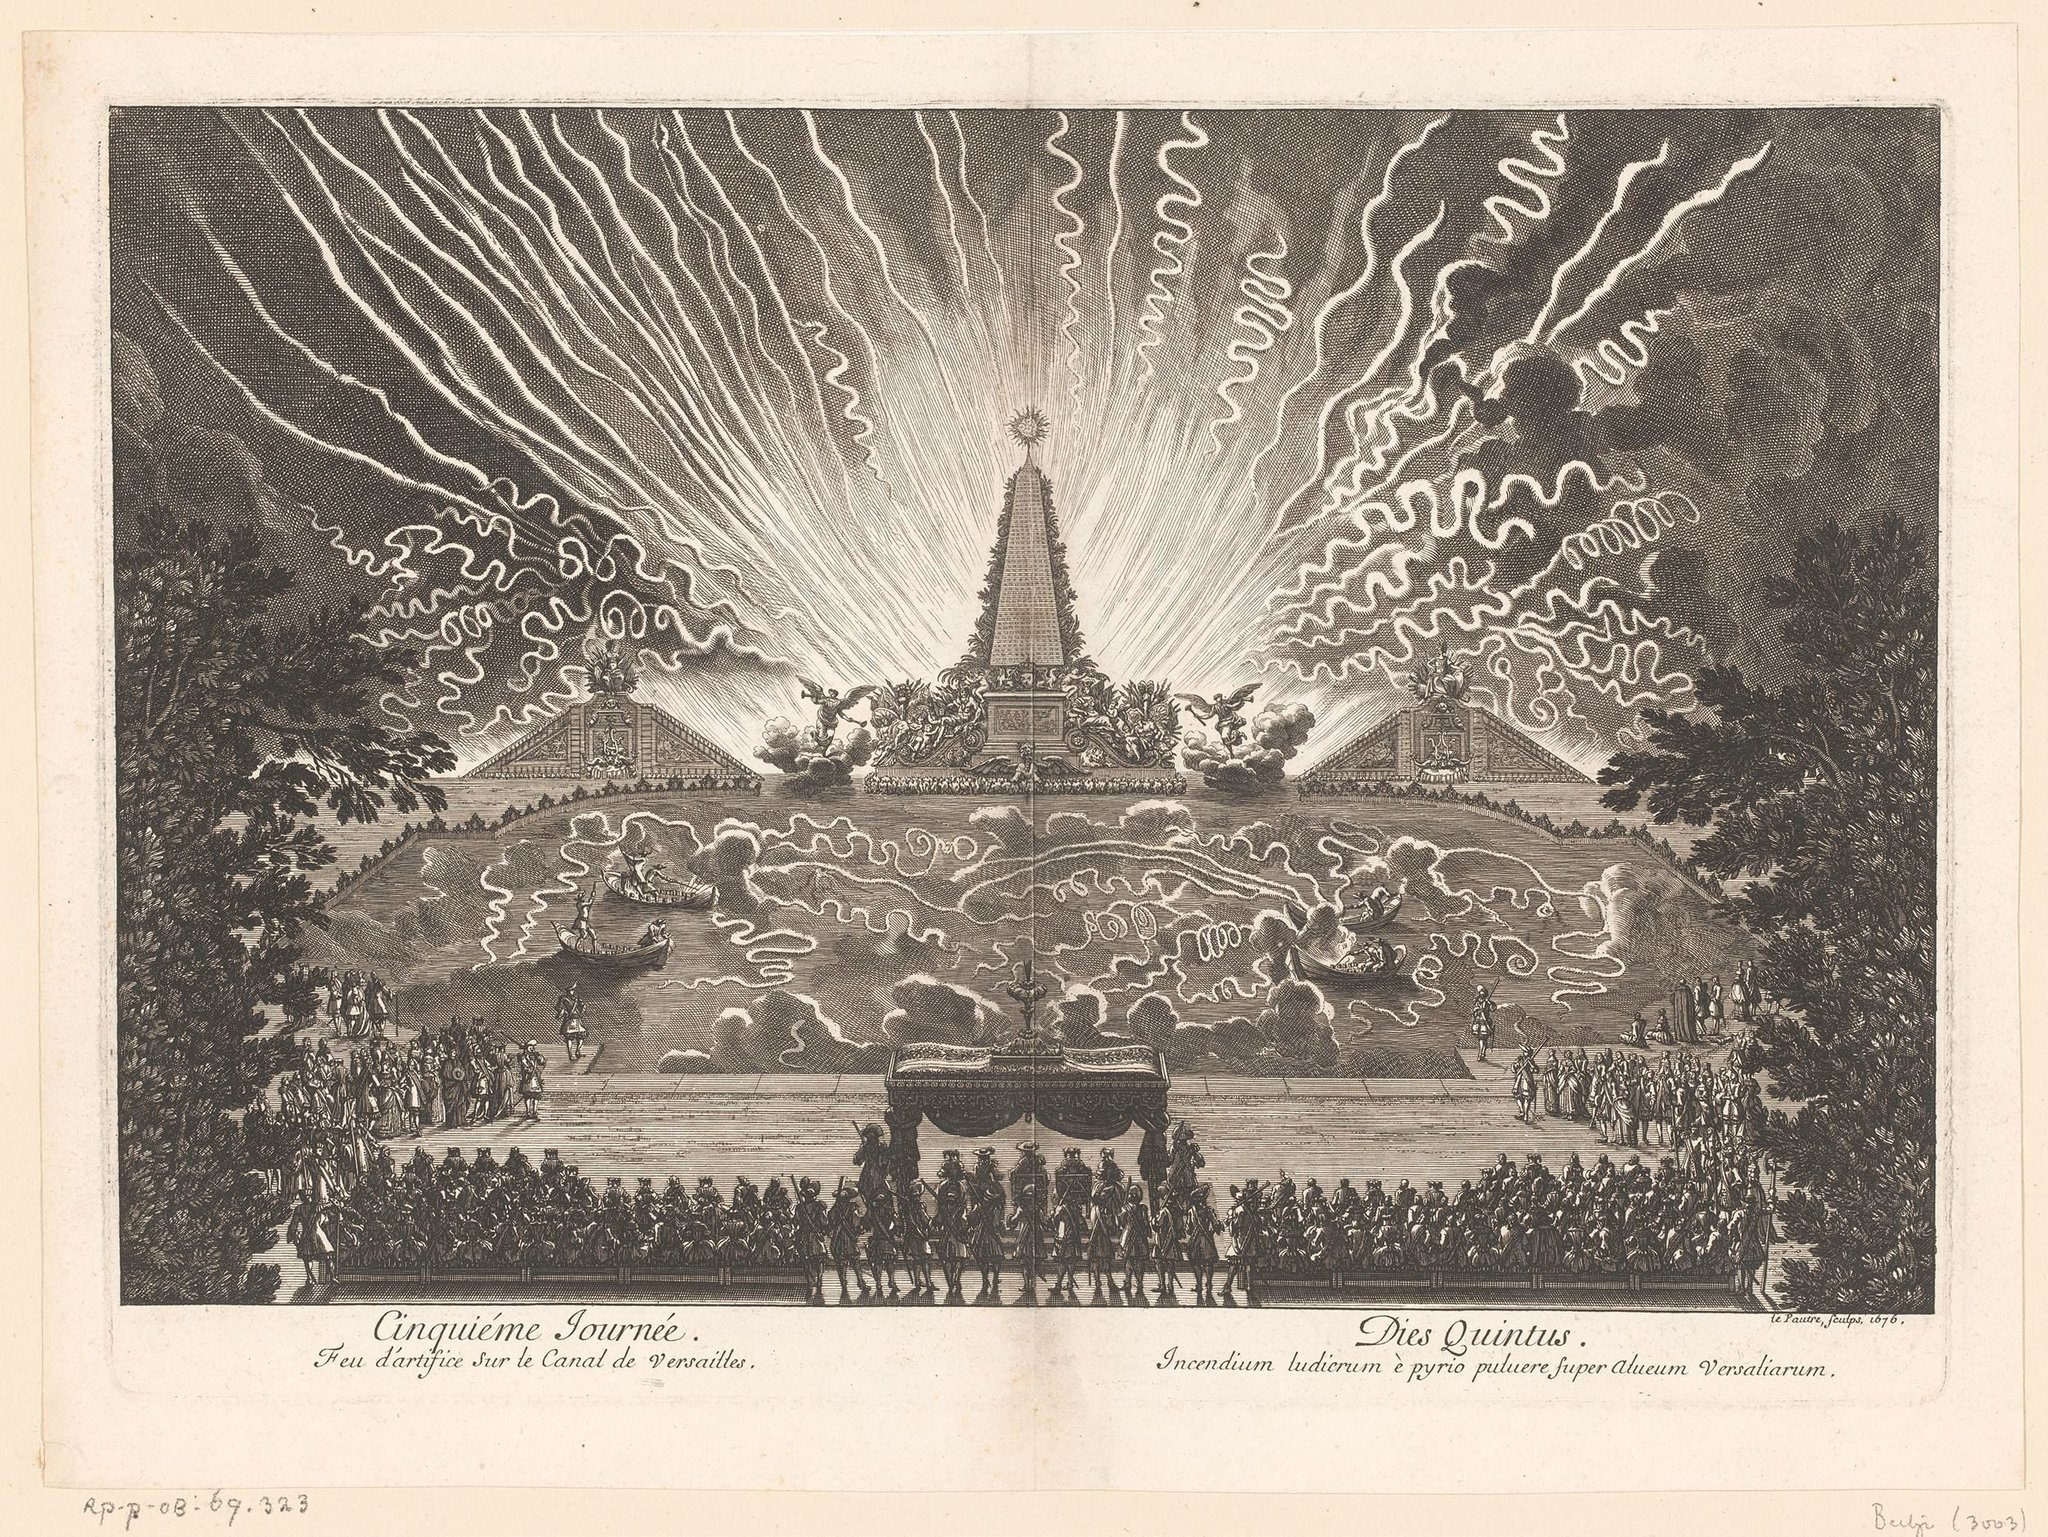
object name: print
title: Les divertissements de Versailles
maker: jean lepautre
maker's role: draughtsman, print maker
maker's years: 1618-1682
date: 1676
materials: paper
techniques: engraving, etching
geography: paris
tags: lodewijk xiv (koning van frankrijk), garden fountain, historical persons, bonfire, fire-works - aa - festivities on the water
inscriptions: collector's mark: Lugt 240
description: Maakt deel uit van een vijfdelige serie met voorstellingen van de festiviteiten die door Lodewijk XIV in Versailles gehouden werden na de verovering van Franche-Comté in 1674. De serie bestaat uit prenten door verschillende kunstenaars, werd voorzien van tekst door André Félibien en werd uitgegeven in 1676 door de Imprimerie Royale te Parijs. De serie werd opgenomen in 'Cabinet du Roy', dl. 11. Zie IFF 17e siècle, p. 318 en British Museum inv.nr. 1889,1218.145.